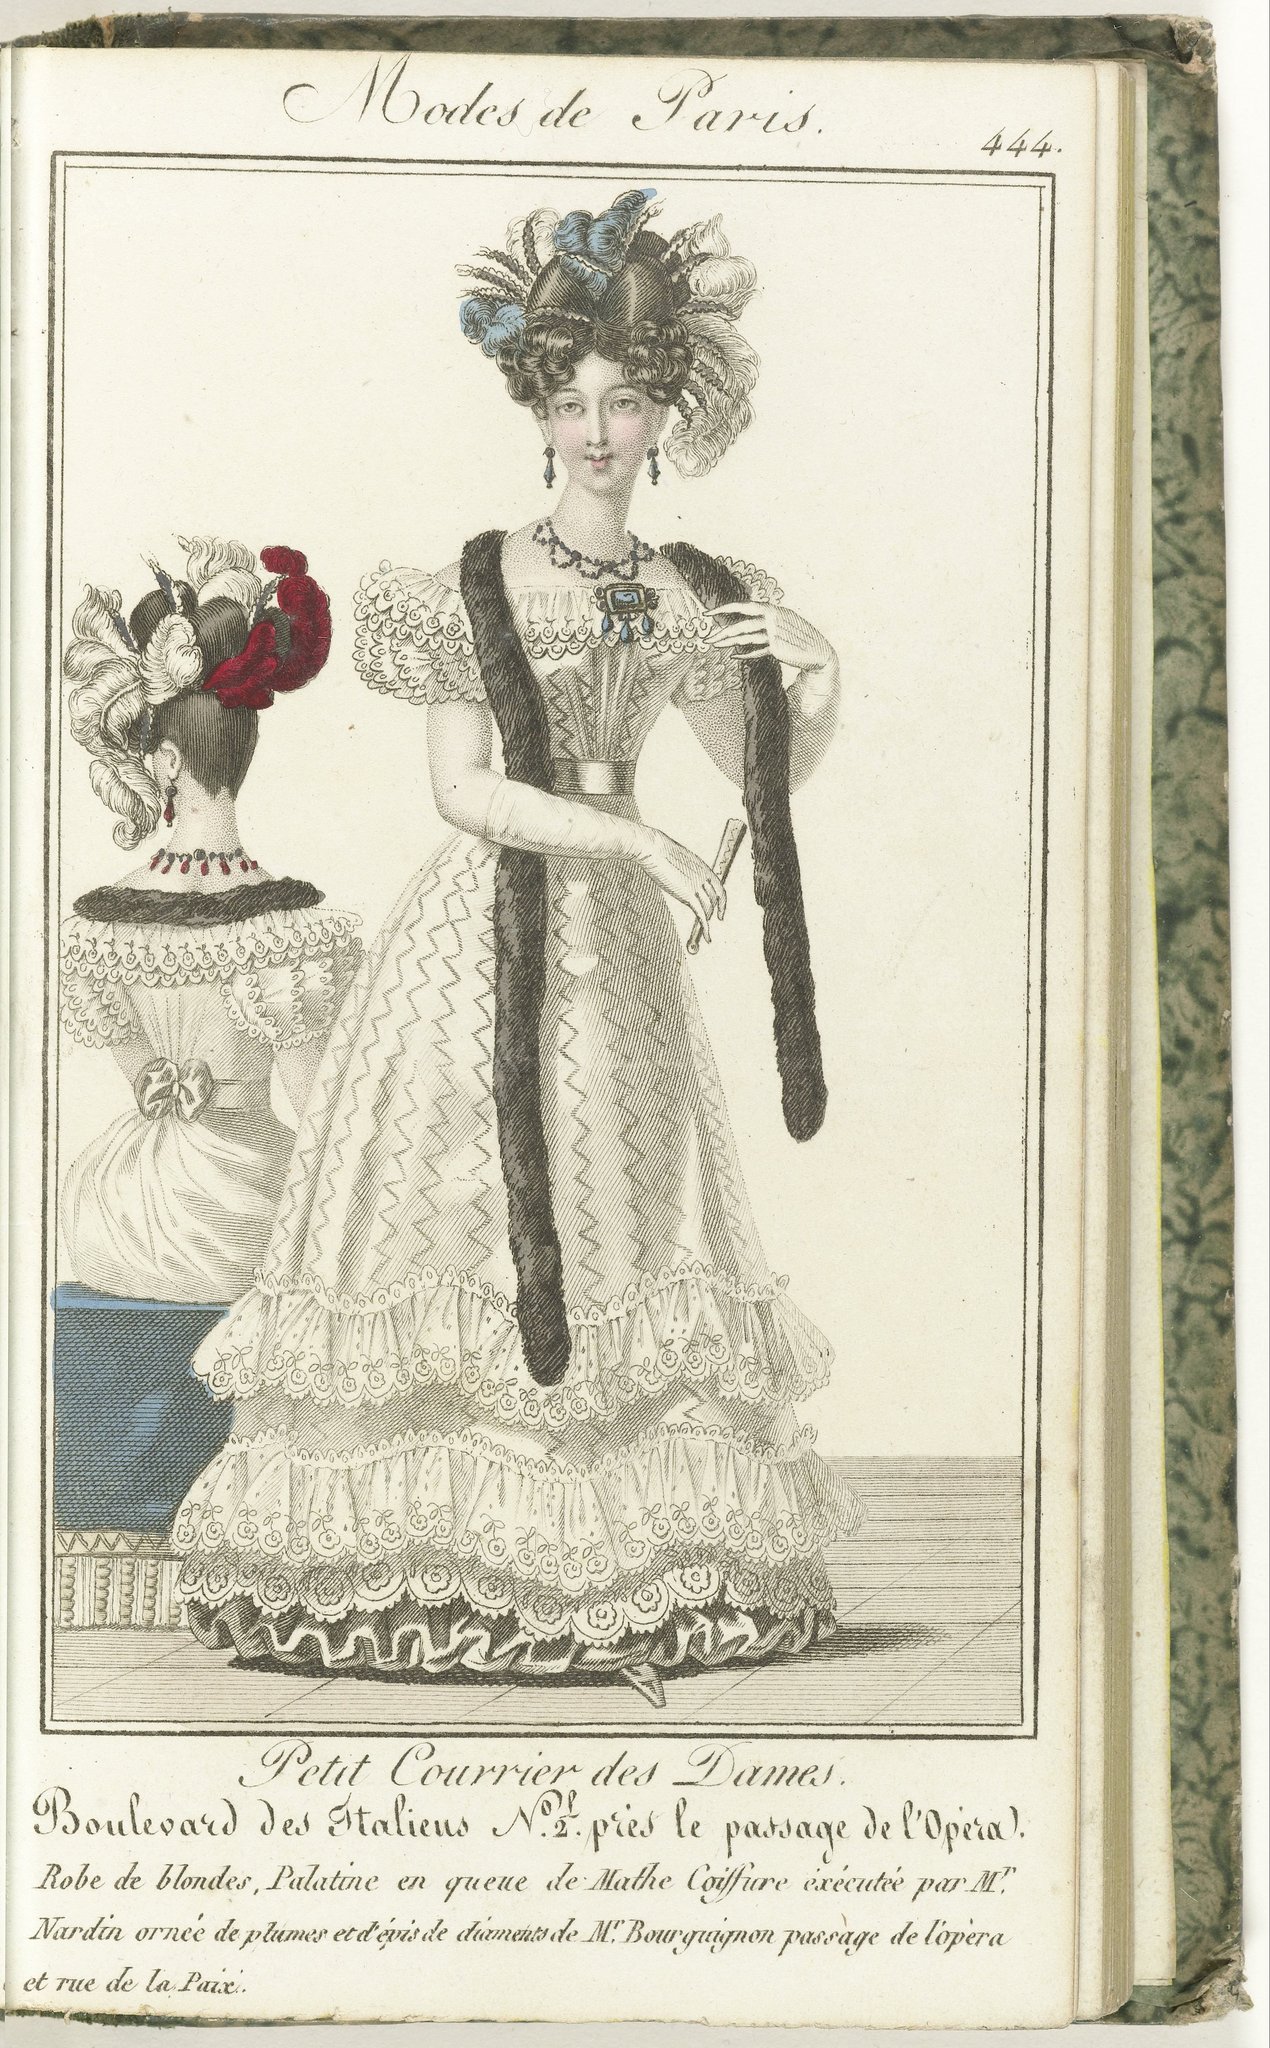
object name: fashion print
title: Petit Courrier des Dames, 25 janvier 1827, No. 444 : Robe de blondes, Palatine...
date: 1827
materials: paper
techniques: engraving, hand coloring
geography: paris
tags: brooch, agraffe, clasp (+ women's clothes), gloves, mittens (long gloves) (+ women's clothes), lace (+ women's clothes), neck-gear ~ clothing (palatine) (+ women's clothes), styles of hairdress - aa - ~ women, fashion plates, dress, gown (+ women's clothes), fan (+ women's clothes), necklace (+ women's clothes)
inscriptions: caption: ‘Robe de blondes, palatine en queue de Mathe Coiffure éxécutée par M.r Nardin ornée de plumes et de épis de diaments de M.r Bourguignon passage de l'opèra et rue de la Paix.’, title: ‘Modes de Paris.’, address: ‘Boulevard des Italiens No.2 près le passage de l'Opèra.’, title: ‘Petit Courrier des Dames.’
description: Staande vrouw in een japon van 'blonde' (kloskant). Palatine van marterbont. Coiffure uitgevoerd door Nardin, versierd met veren en aren met diamanten van Bourguignon. Verdere accessoires: oorbellen, collier met hanger, lange handschoenen, waaier. Dezelfde japon op de rug gezien. Prent uit het modetijdschrift Petit Courrier des Dames (1821-1868). Ingebonden (met enkele pp. Le Journal des Dames et des Modes). 15 Januari 1827 t/m 20 maart 1830. Incompleet.